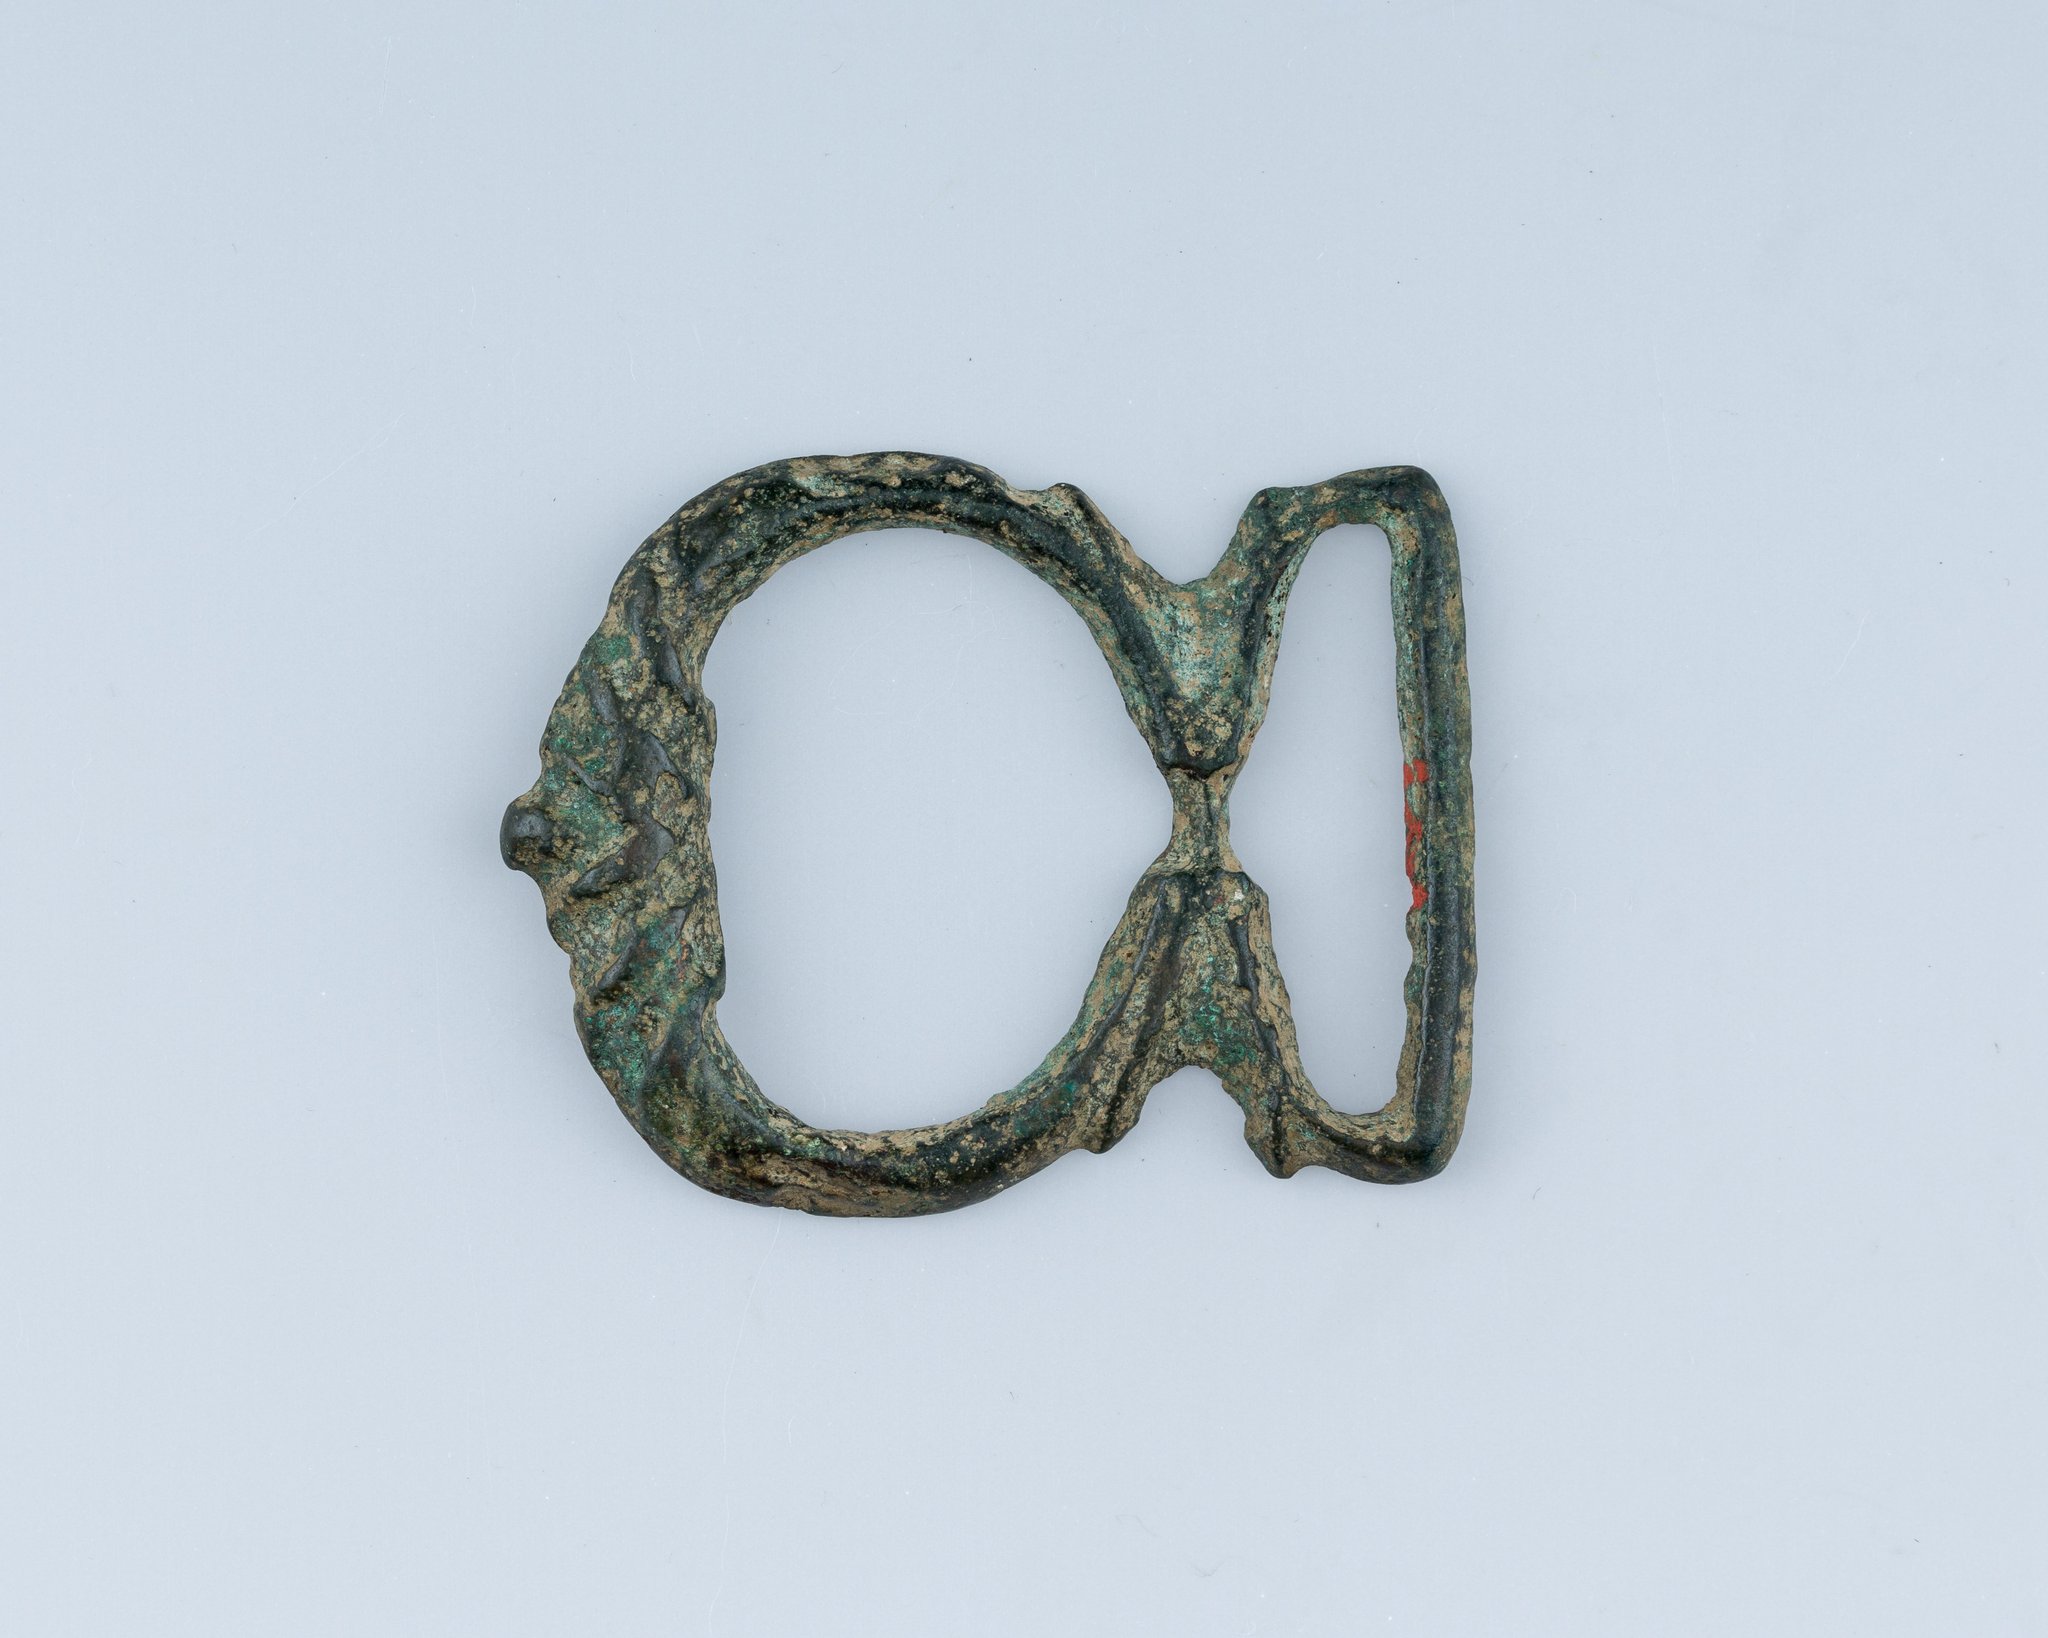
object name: buckle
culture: french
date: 1401-1500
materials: bronze, patina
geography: france